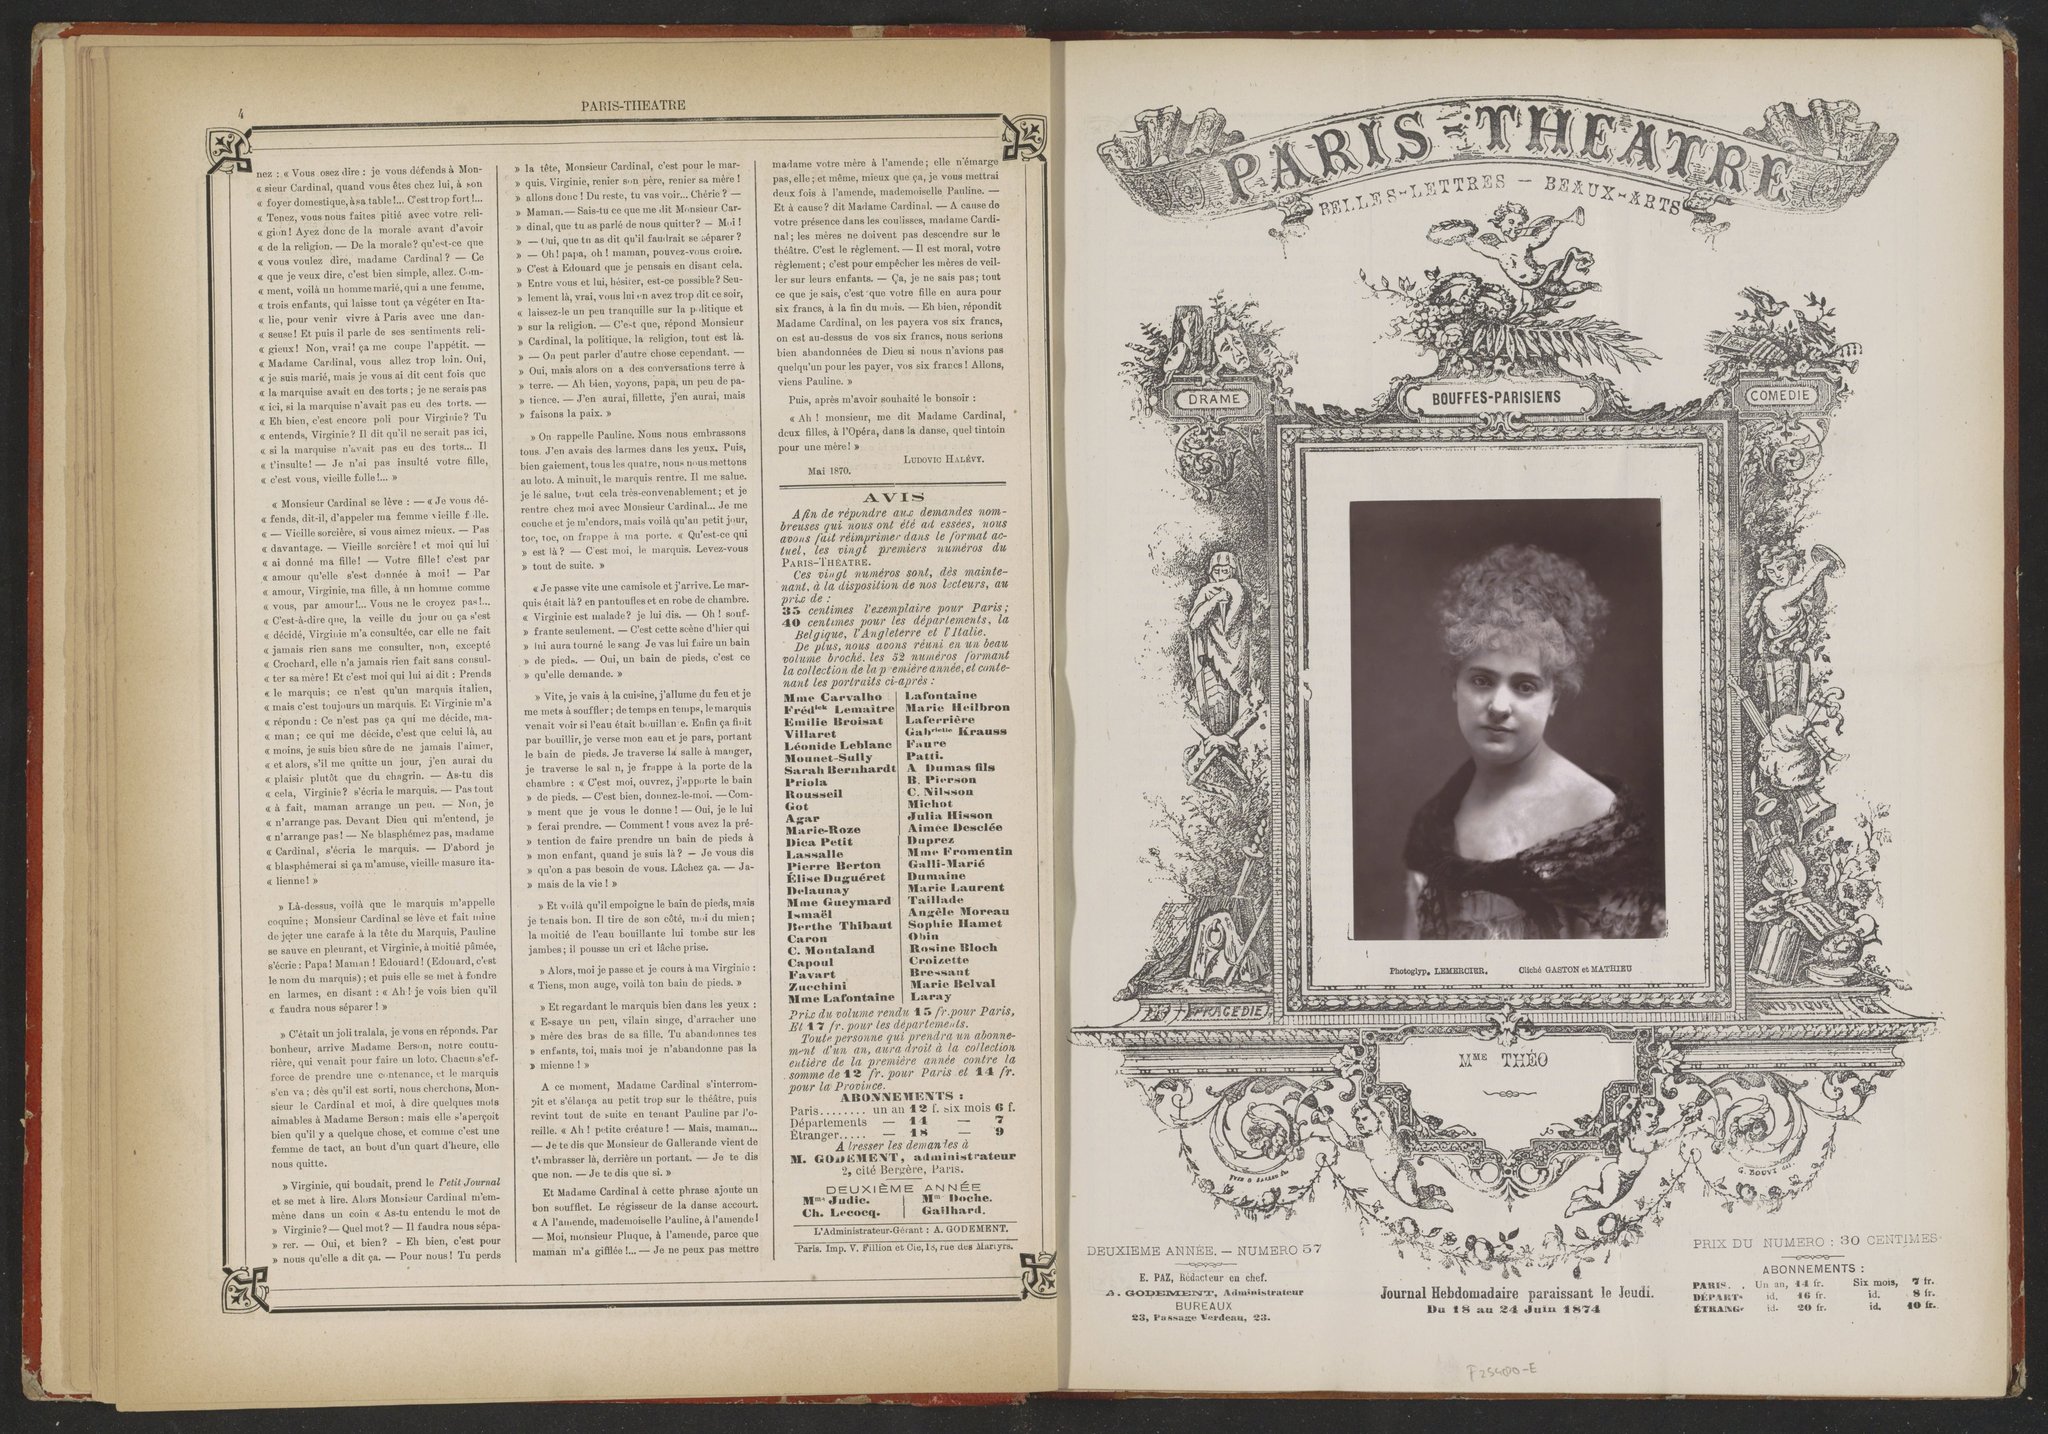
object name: photomechanical print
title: Portret van Louise Théo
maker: joseph rose lemercier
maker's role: printer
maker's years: 1803-1887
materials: paper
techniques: woodburytype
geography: france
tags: portrait of opera-singer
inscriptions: inscription: ‘Journal hebdomadaire paraissant le jeudi Du 18 au 24 Juin 1874’